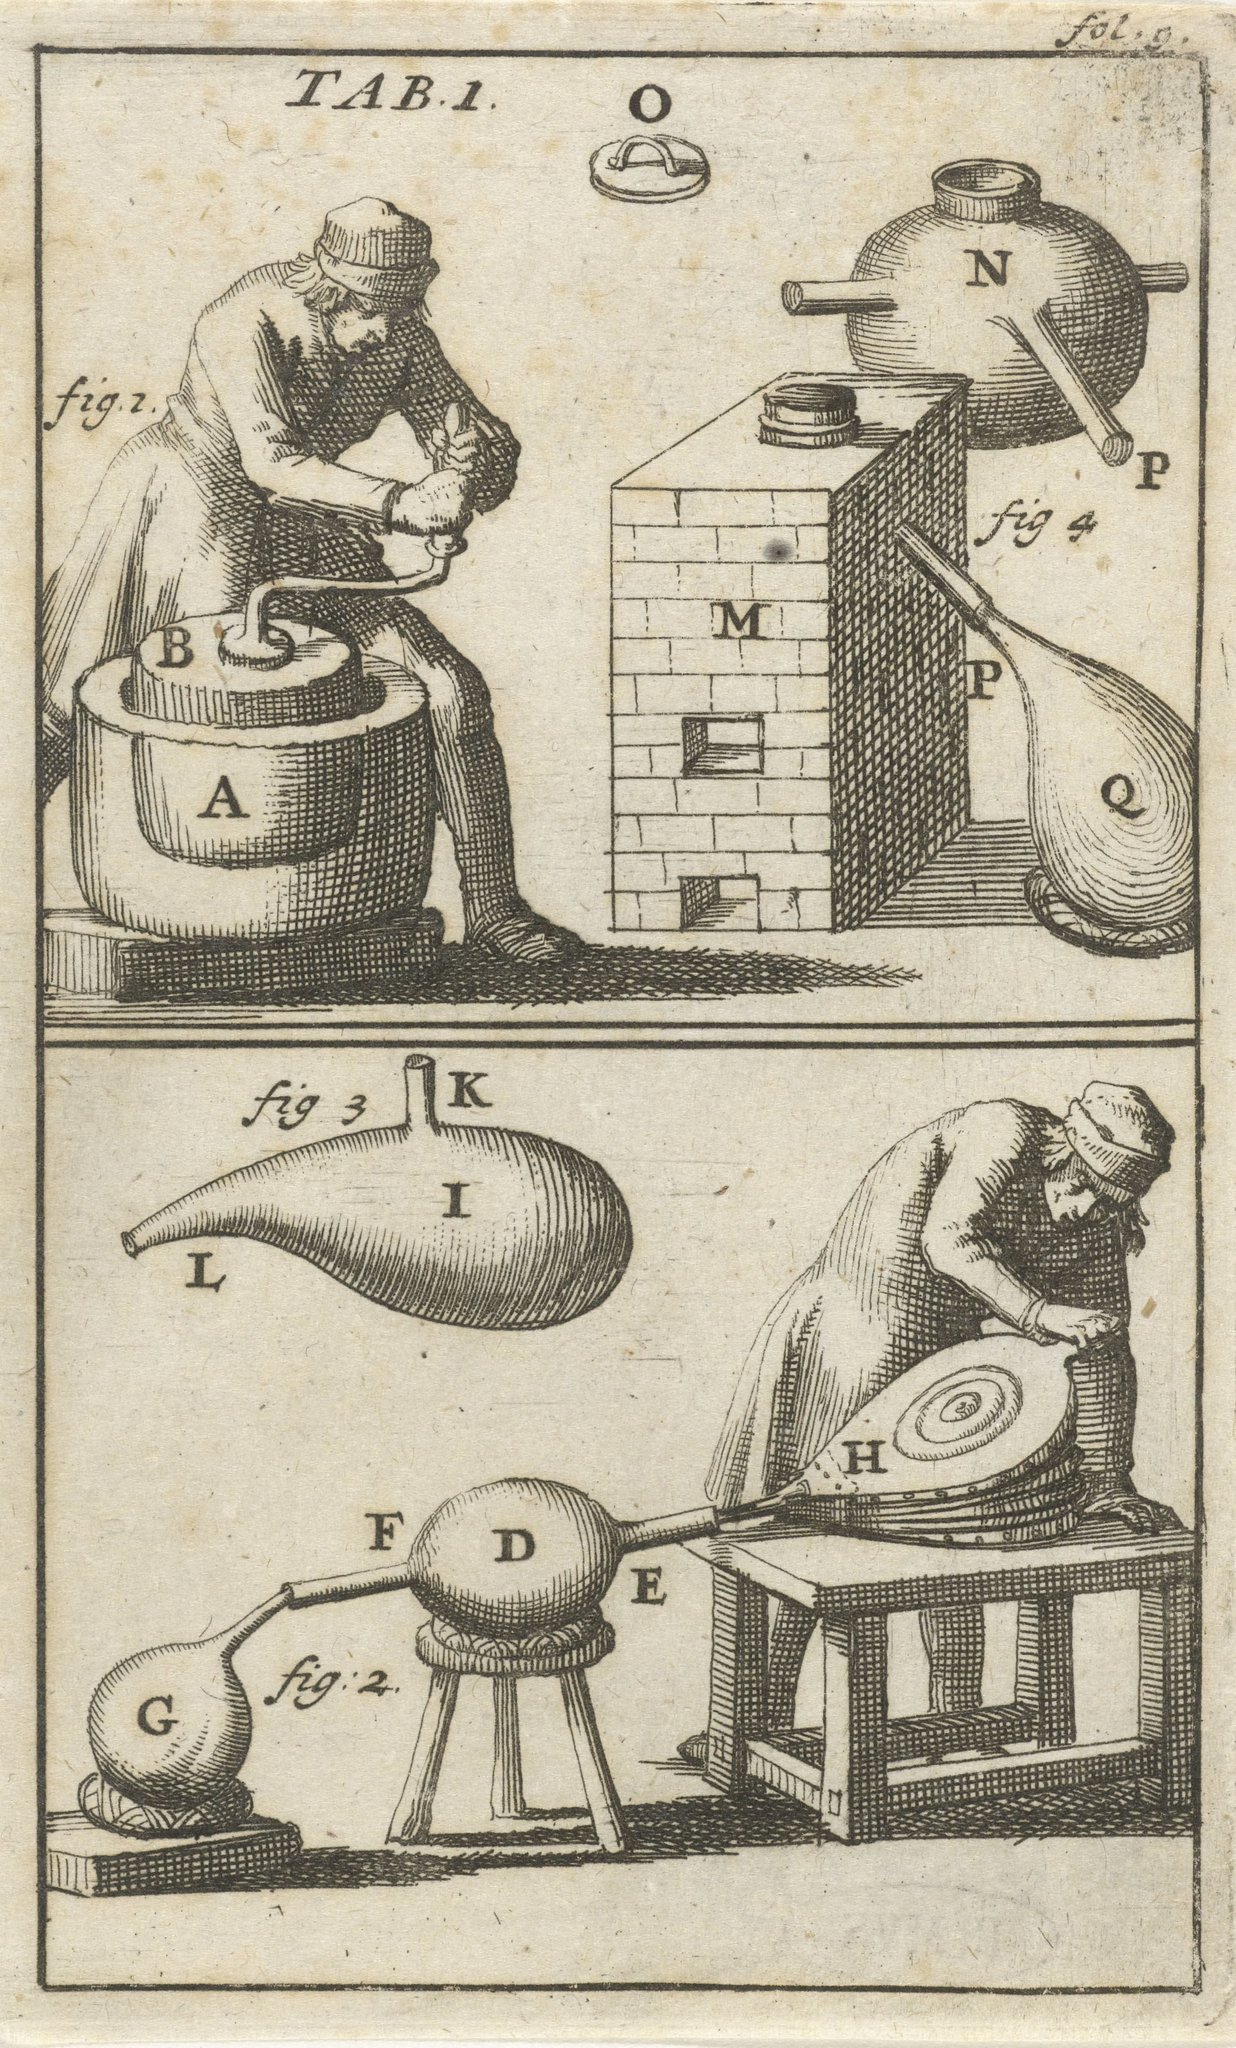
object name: book illustration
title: Twee afbeeldingen van bewerkingen door vermaling en met behulp van een blaasbalg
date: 1693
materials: paper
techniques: etching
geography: amsterdam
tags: smashing, crushing (industrial processes), bellows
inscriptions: collector's mark: Lugt 2228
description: Illustratie uit: Rusting, Salomon van. Nieuwe veld-medicine en chirurgie. Amsterdam: Jan Claesz ten Hoorn, 1693.